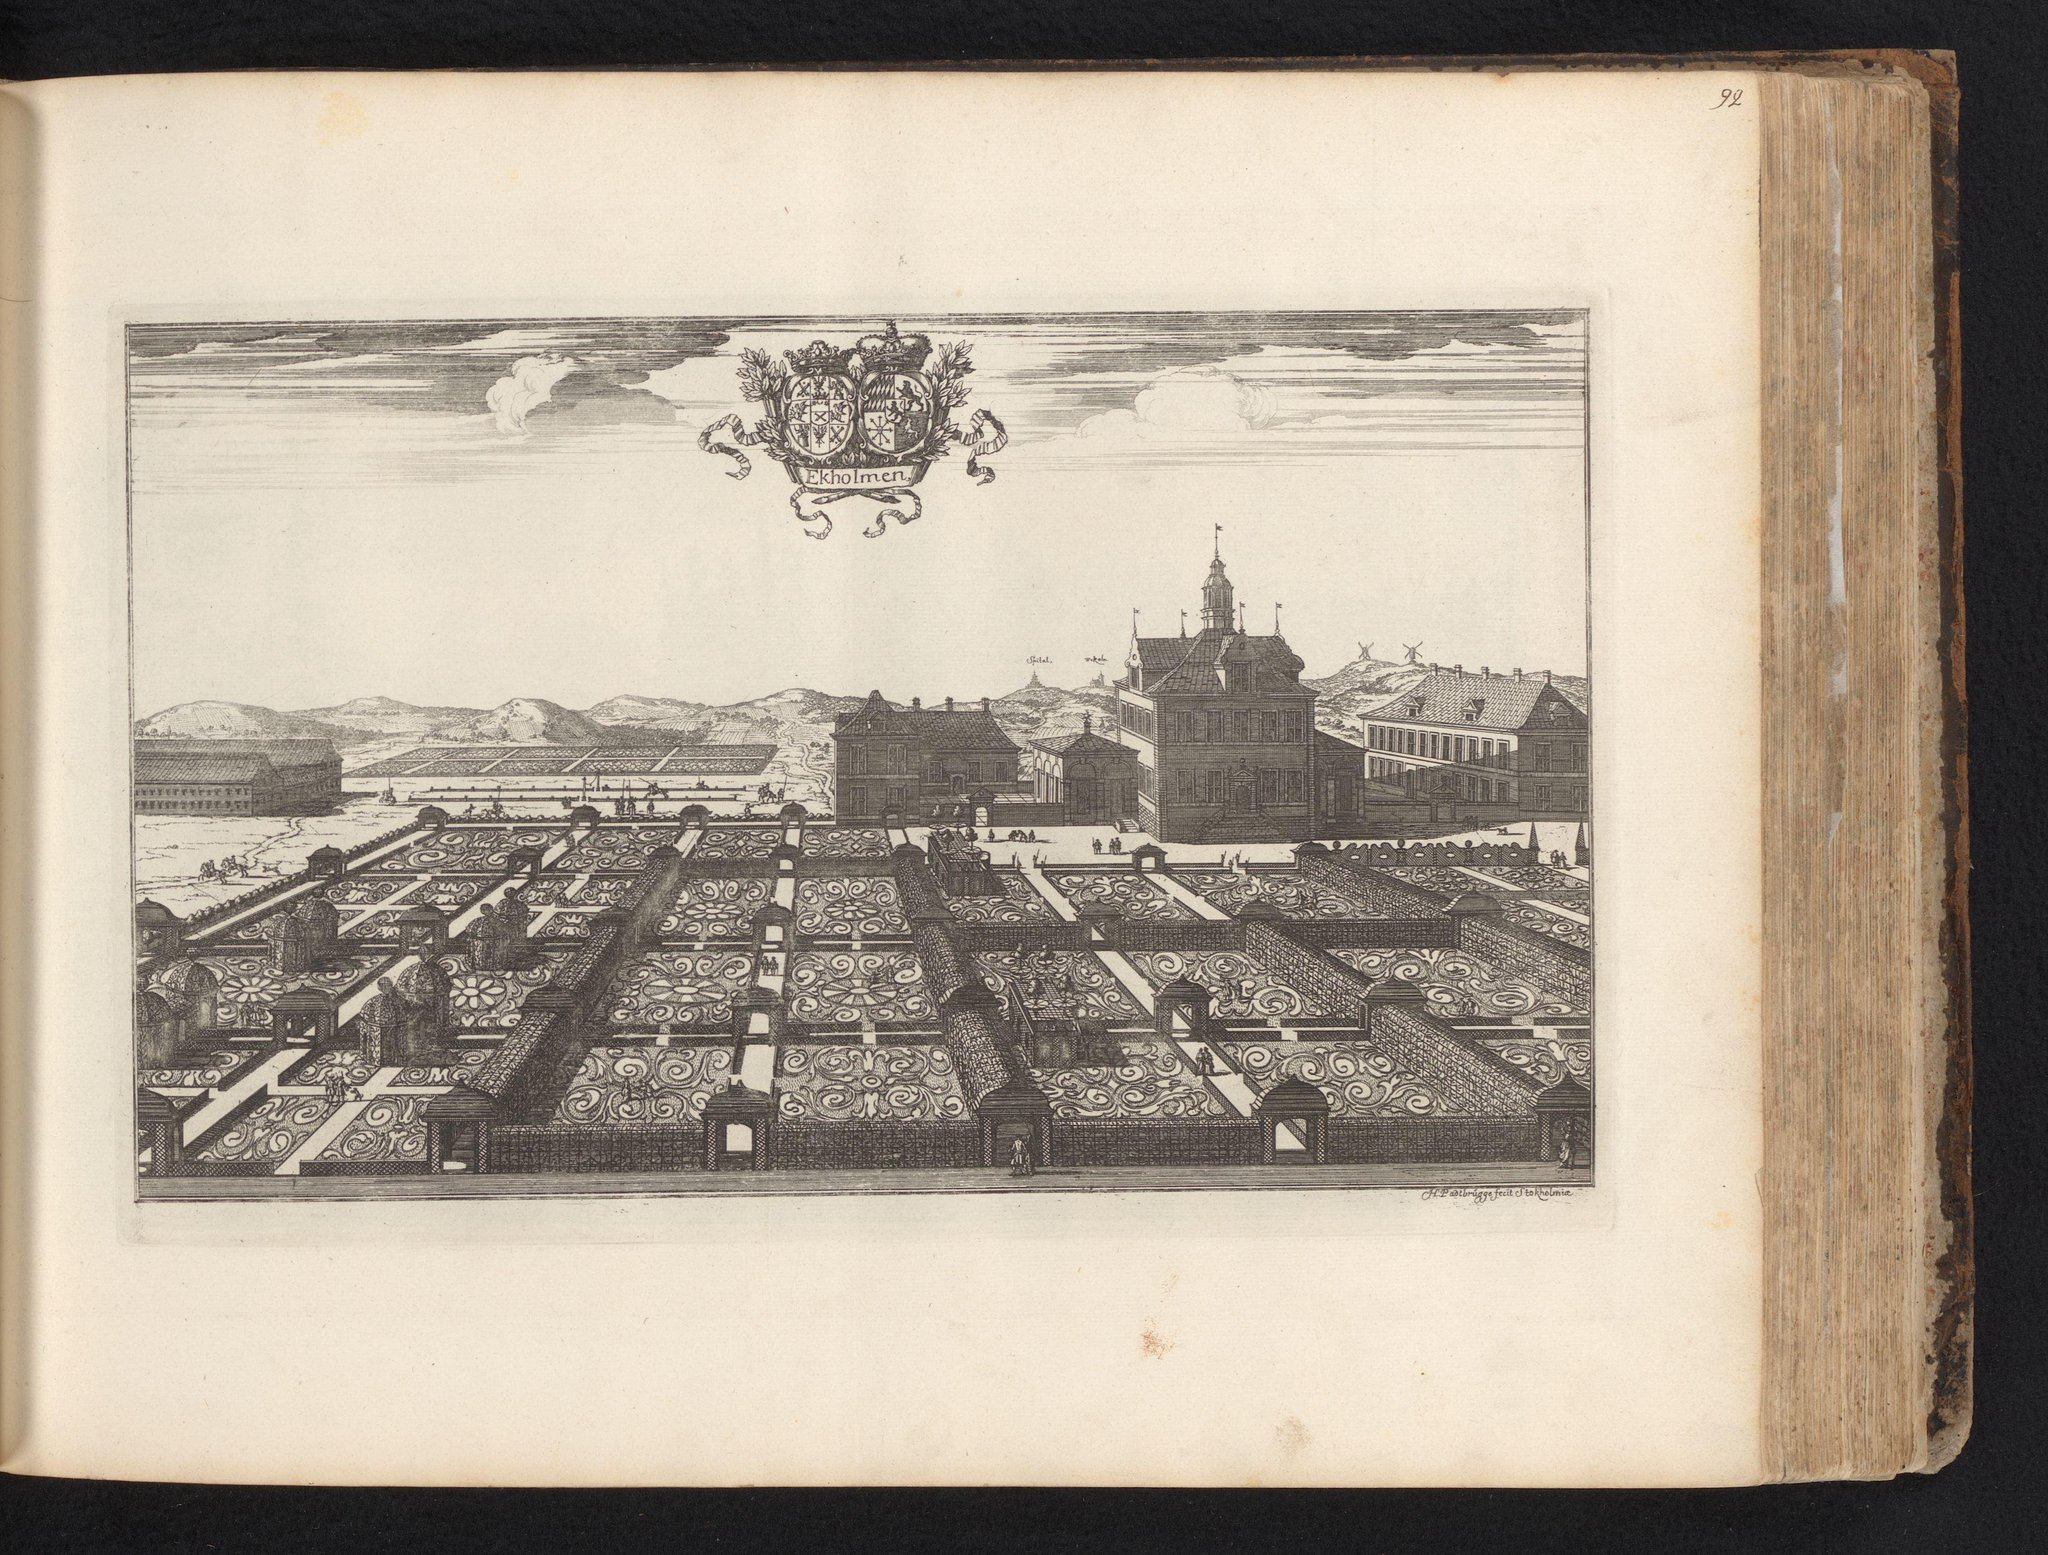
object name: print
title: Gezicht op slot Ekholmen en zijn tuinen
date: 1686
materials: paper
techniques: etching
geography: stockholm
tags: garden, palace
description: Kungliga Biblioteket, 'Suecia': http://www.kb.se/samlingarna/Kartor-bilder/Suecia-antiqua/ (geraadpleegd november 2016).